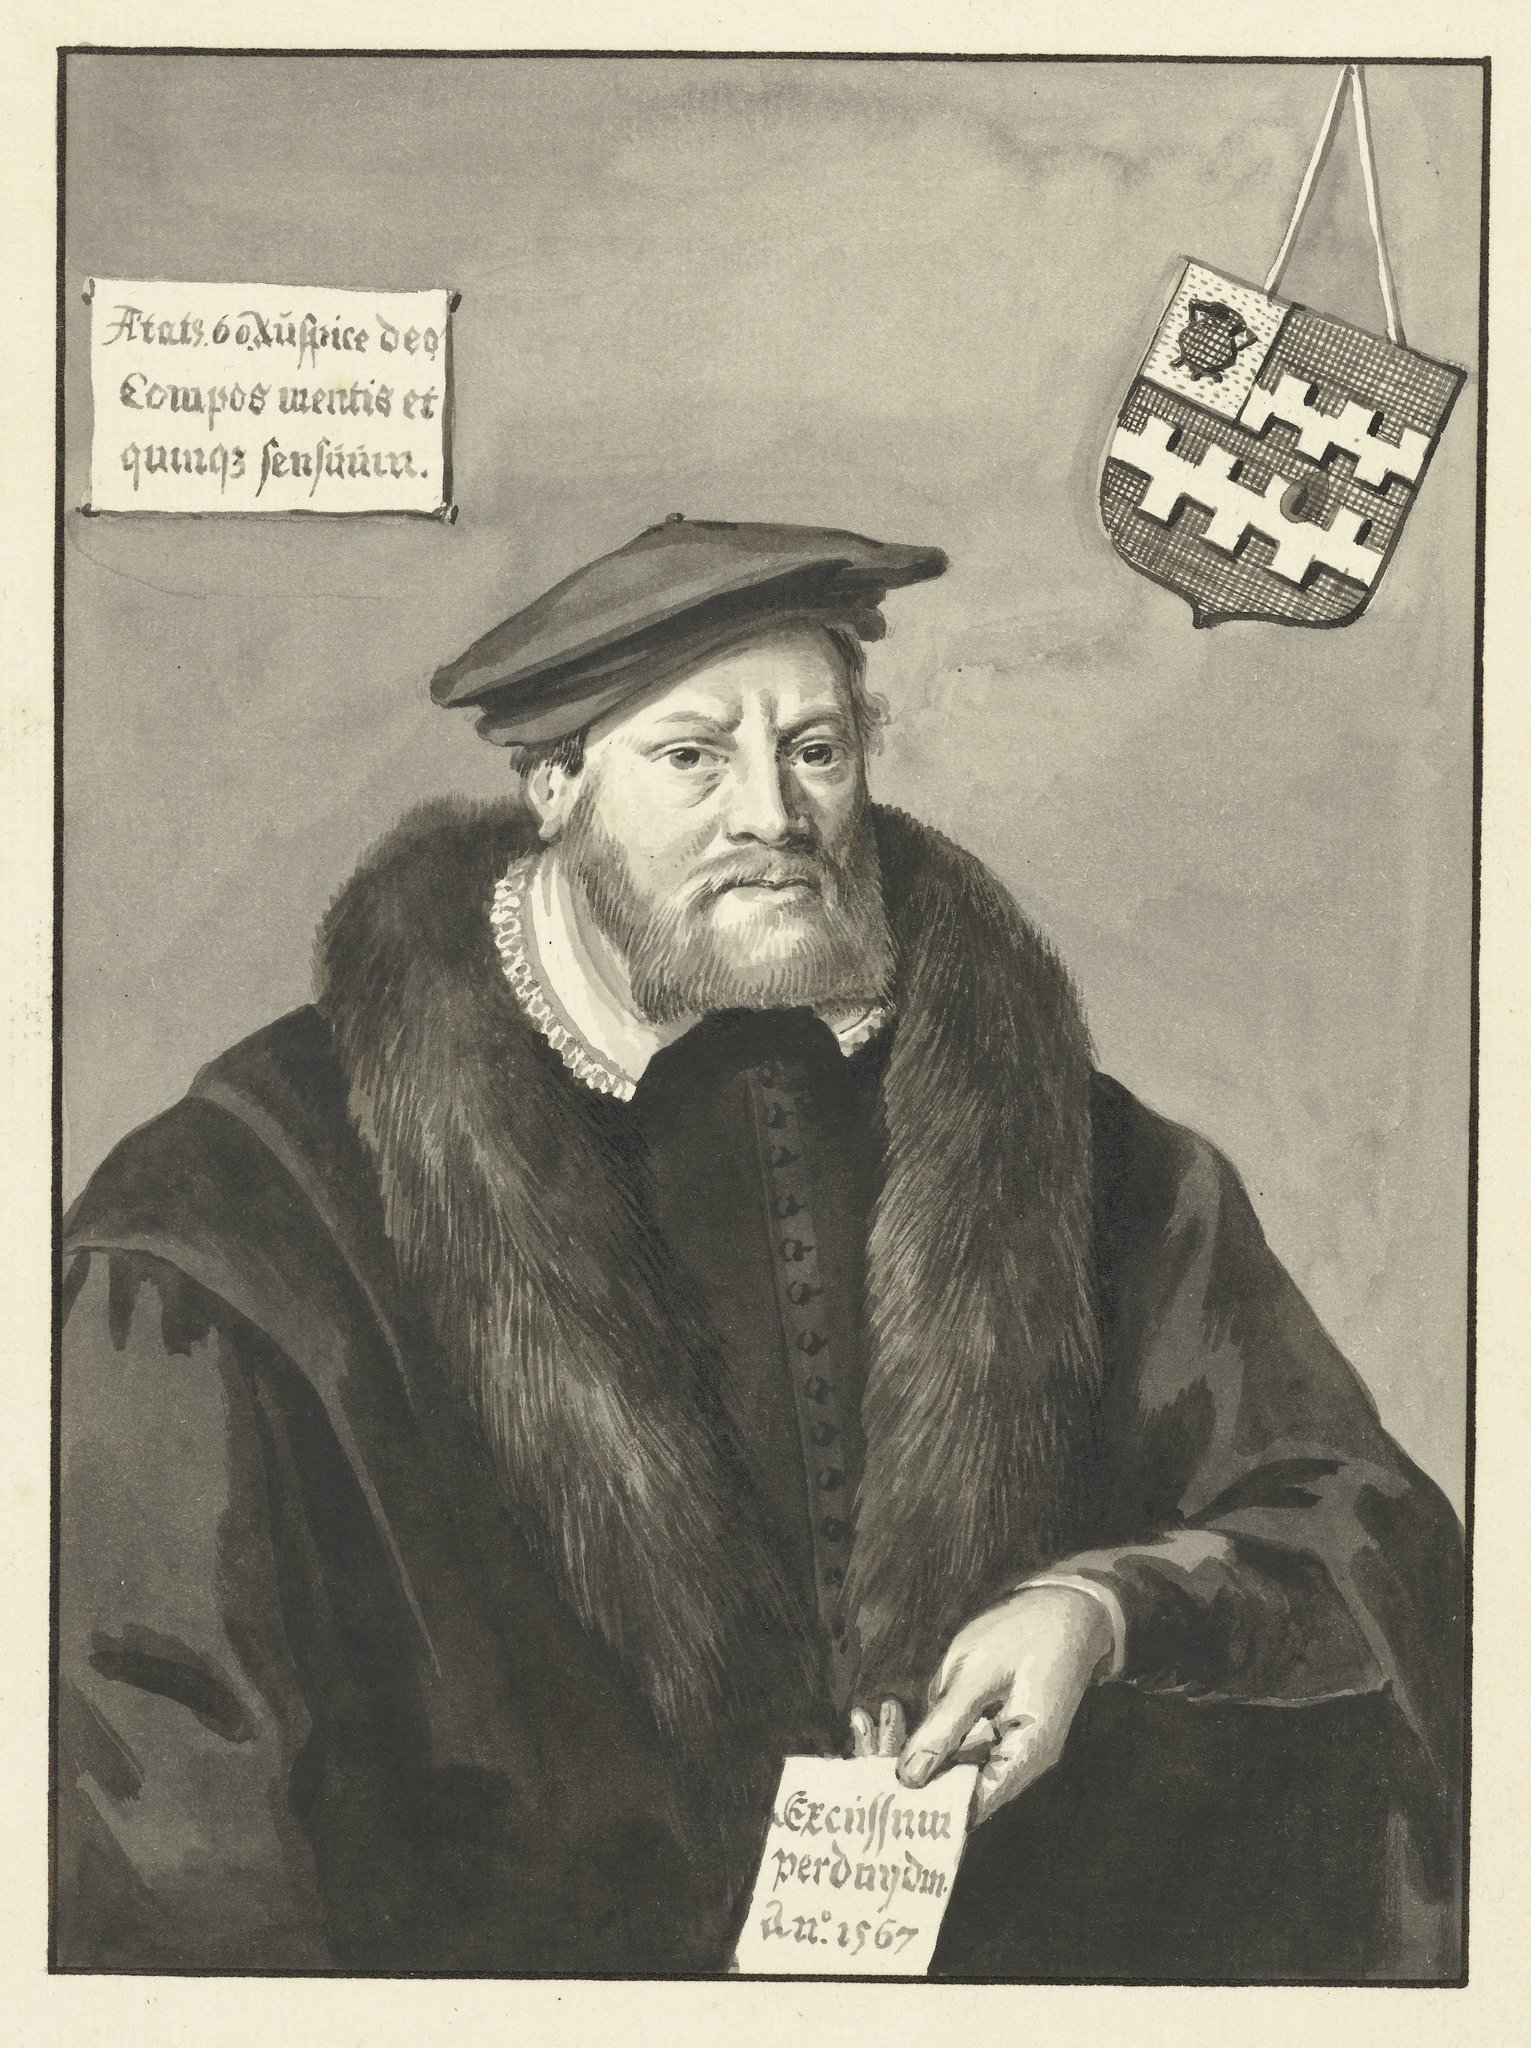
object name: drawing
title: Portret van een man met bontkraag en pet, met het familiewapen van Van Slingelandt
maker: aert schouman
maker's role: draughtsman, painter, print maker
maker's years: 1710-1792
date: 1751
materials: ink, paper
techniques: brush, pen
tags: historical persons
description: Portret van een man met bontkraag en pet, met het familiewapen van Van Slingelandt. Linksboven, op papiertje: AEtats 60 Auspice deo / Compos mentis et / quinqe sensuum. Op papiertje in de linkerhand: Excissum / per duydui [?] / ano 1567.